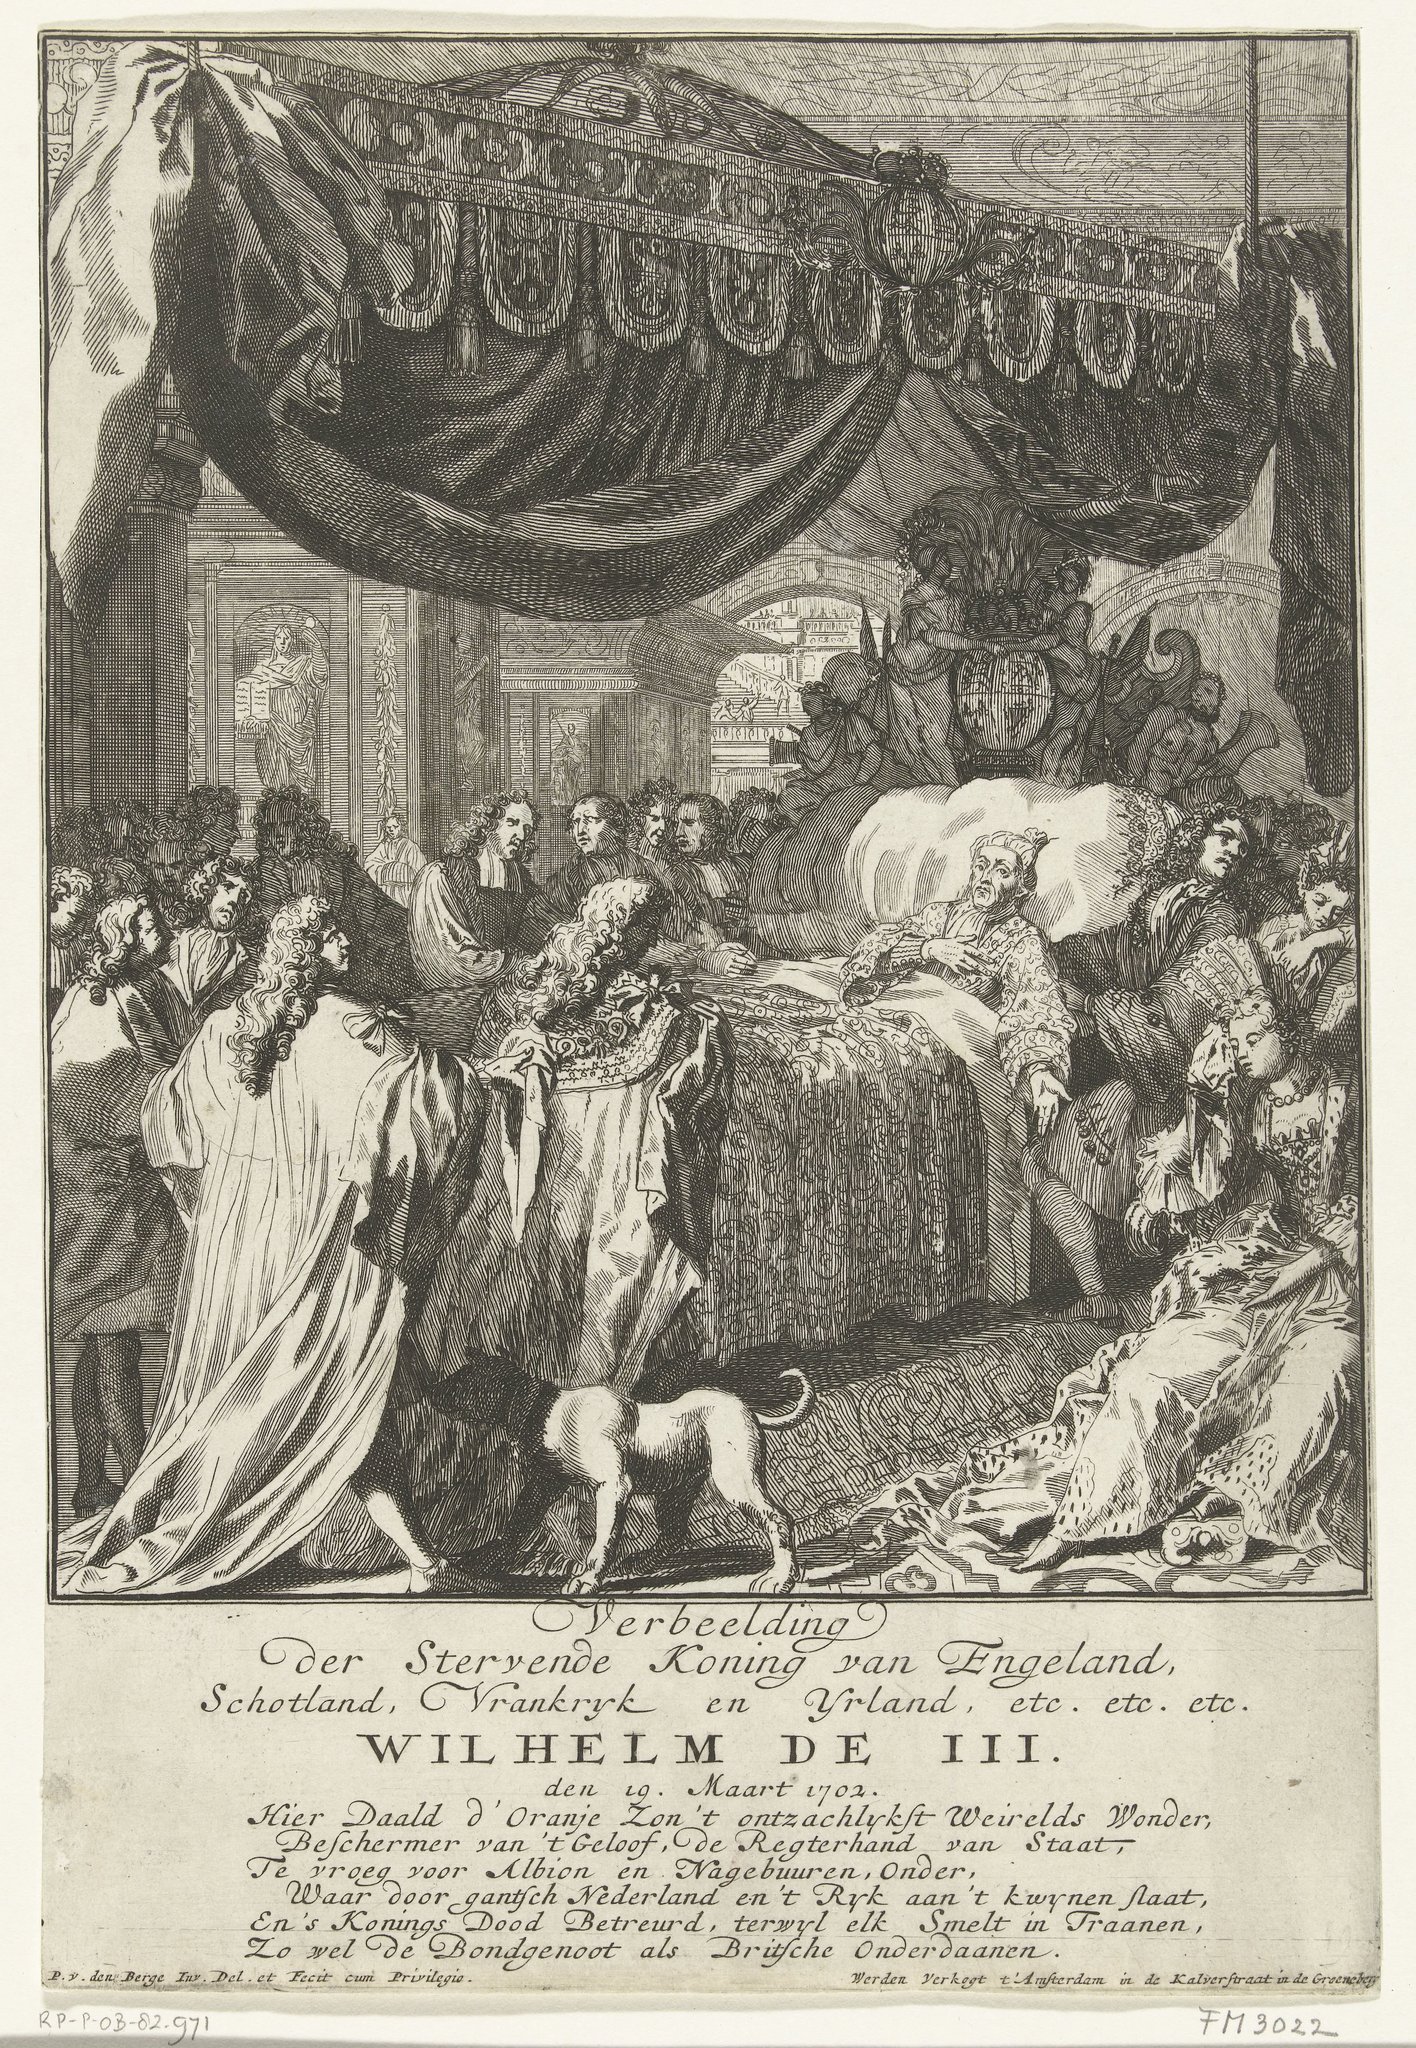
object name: print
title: Sterfbed van koning Willem III, 1702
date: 1702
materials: paper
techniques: engraving, etching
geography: amsterdam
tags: the hague, william iii (prince of orange and king of england, scotland, and ireland), deathbed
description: Sterfbed van koning Willem III in het paleis te Londen, 19 maart 1702. De koning overlijdt aan de gevolgen van een val tijdens een jachtpartij op 4 maart. Het bed omringd door geestelijken, hoogwaardigheidsbekleders en leden van de hofhouding. In het onderschrift een vers van zes regels.